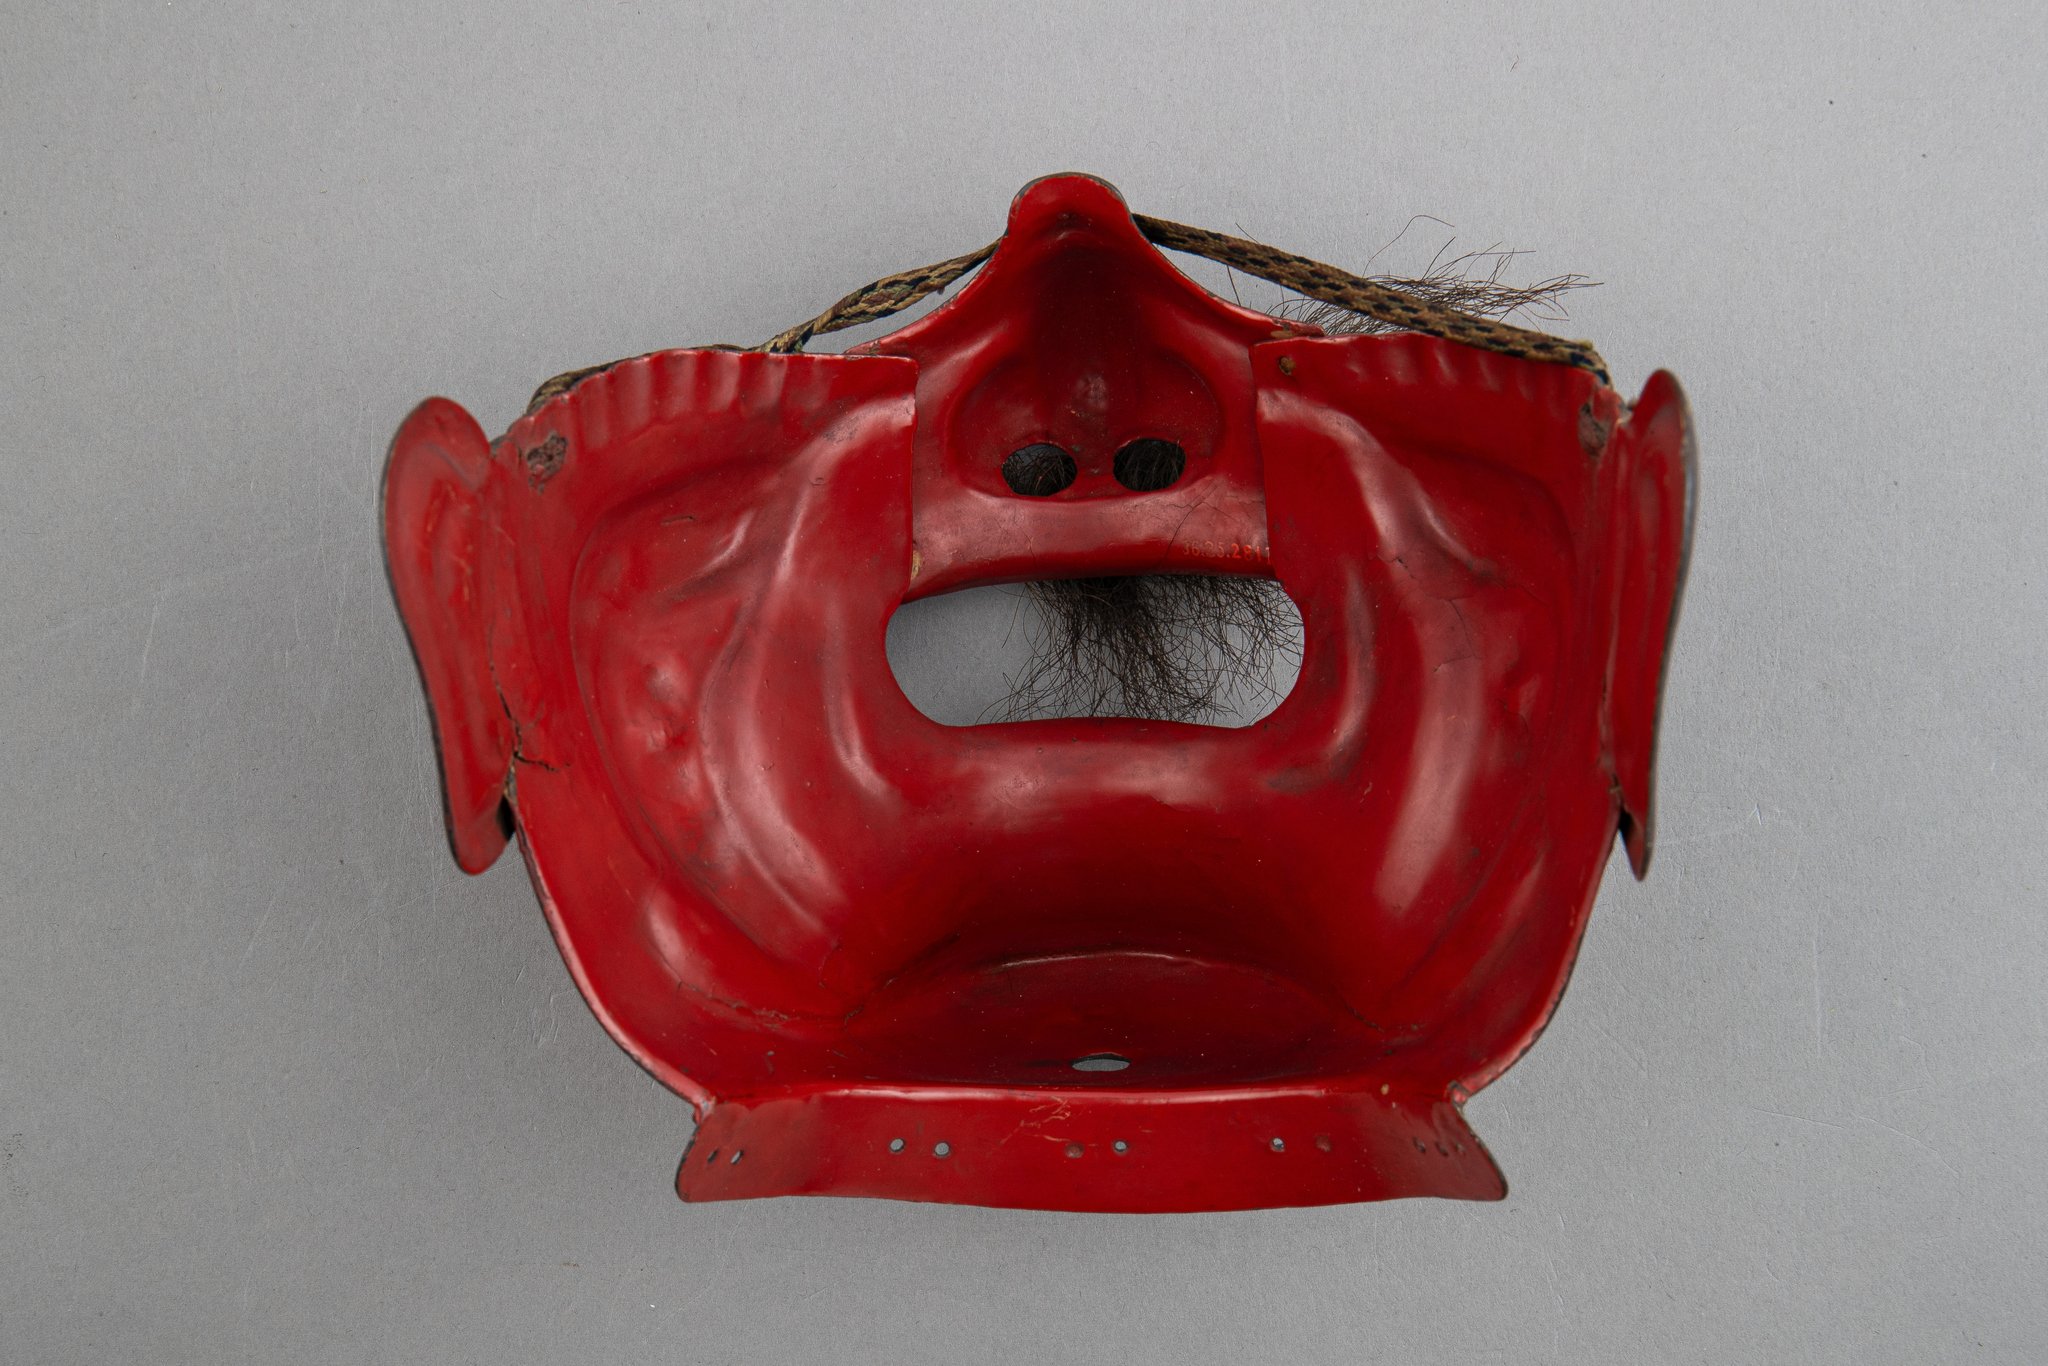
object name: half mask menpō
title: Half Mask (Menpō)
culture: japanese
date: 1615-1868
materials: hair, iron, lacquer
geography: japan